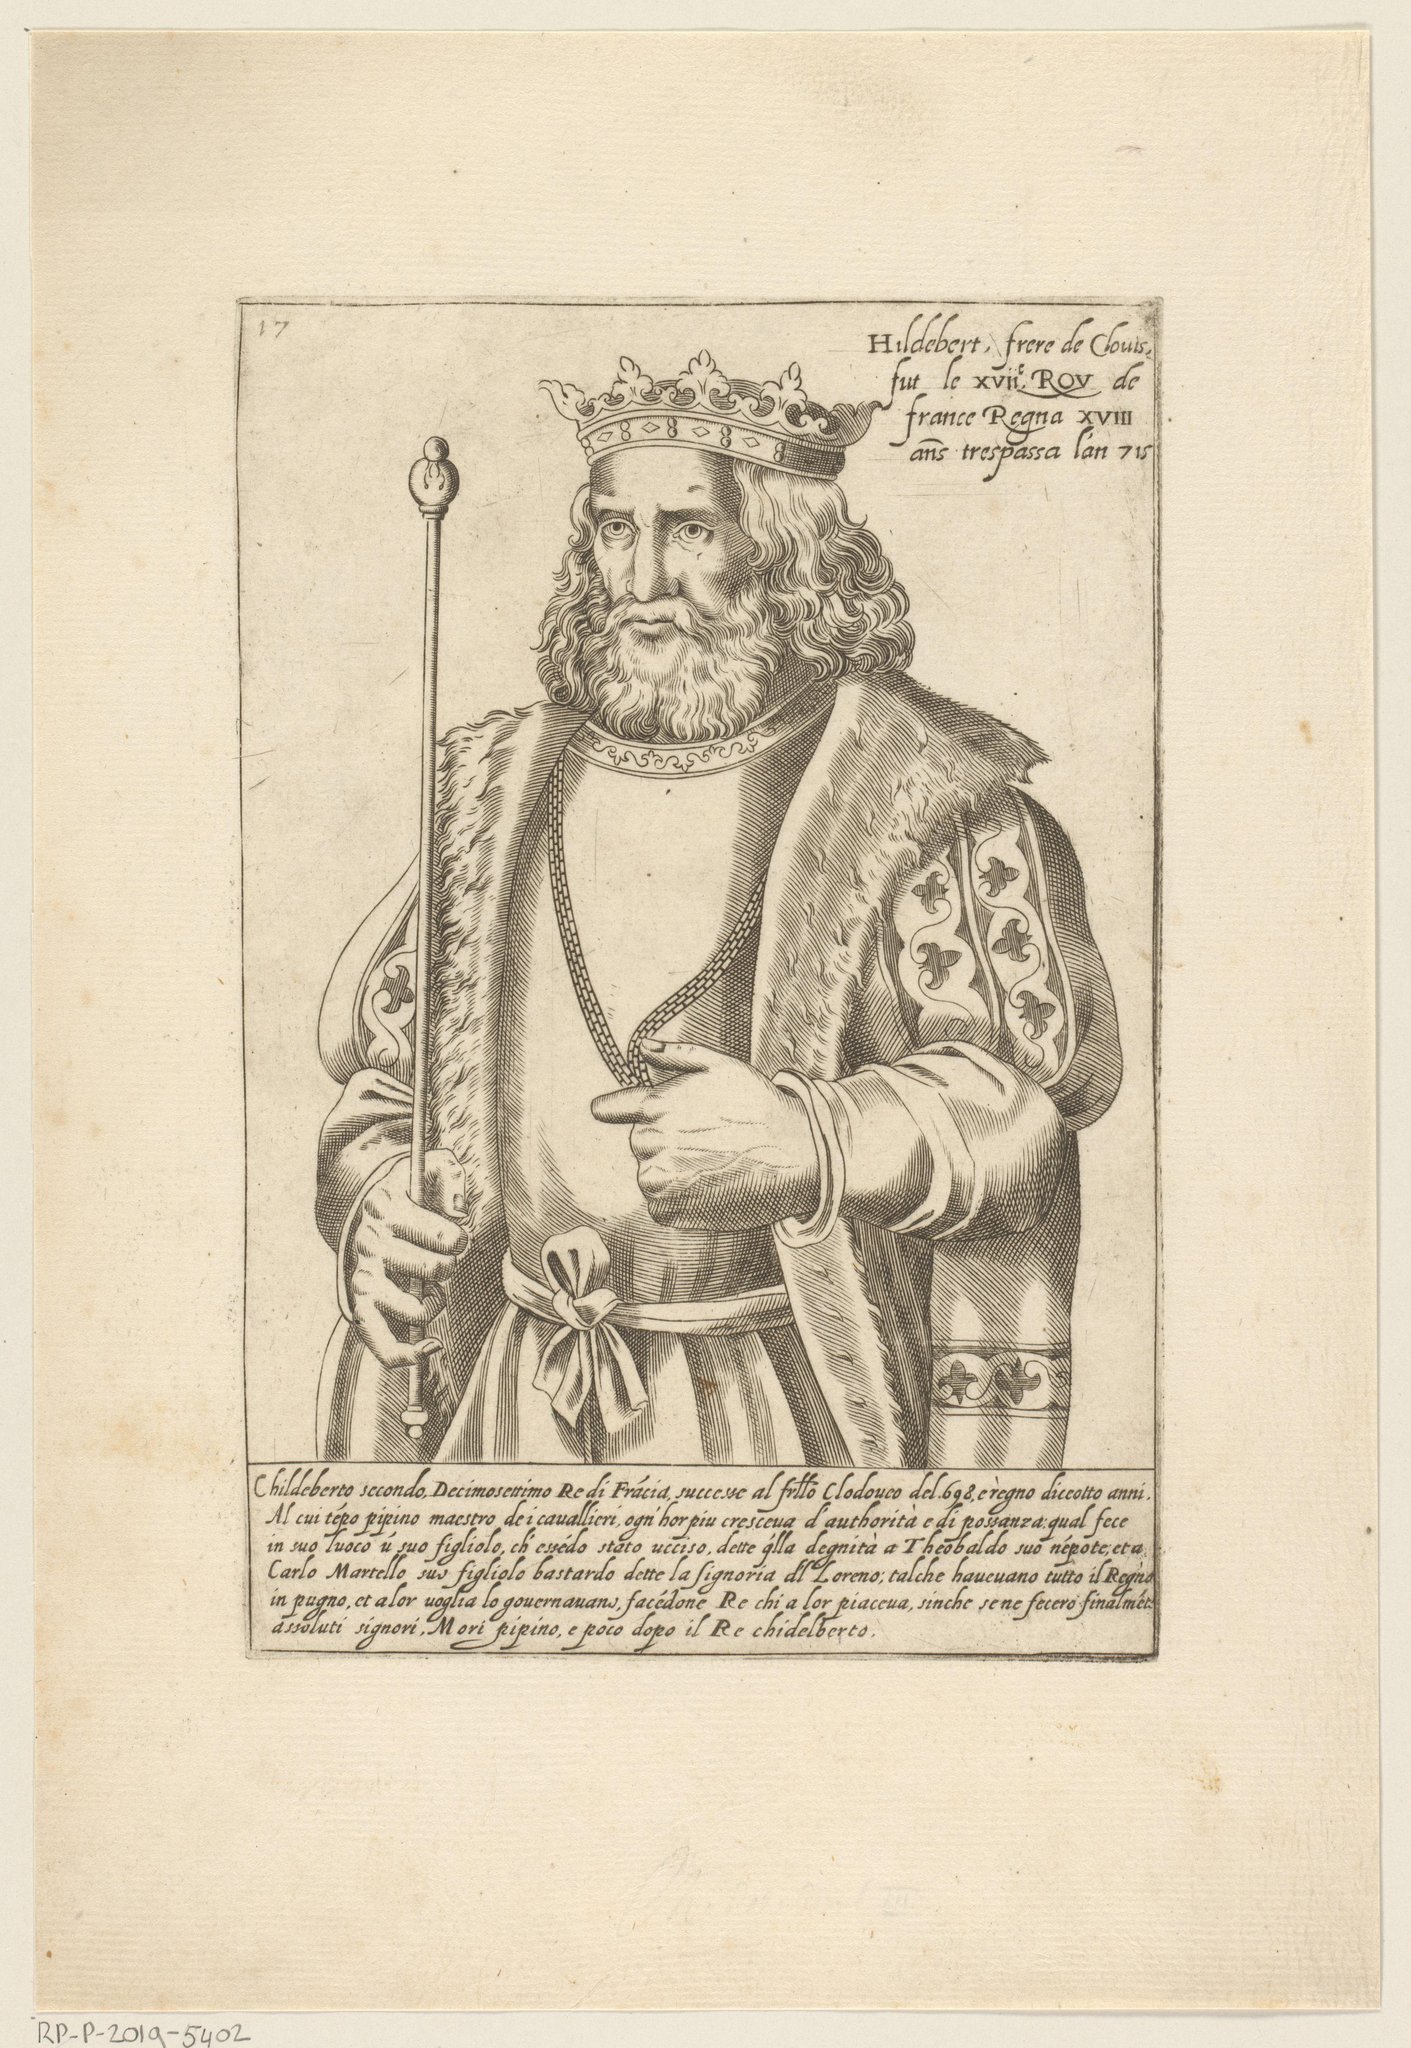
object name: print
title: Portret van Childebert III, koning van Austrasië, Bourgondië en Neustrië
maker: Anonymous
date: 1588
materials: paper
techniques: engraving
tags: crown (symbol of sovereignty), sceptre, staff (symbol of sovereignty), historical persons, king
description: Prent voor het eerst gebruikt in: Cronica Breve de i fatti illustri de're di Francia, con le loro effigie dal naturale cominciando da Faramondo (...). Venetië: Bernardo Giunti, 1588. Prent in ieder geval ook gebruikt in de editie van 1590 en mogelijk ook in een Franse uitgave van 1597.